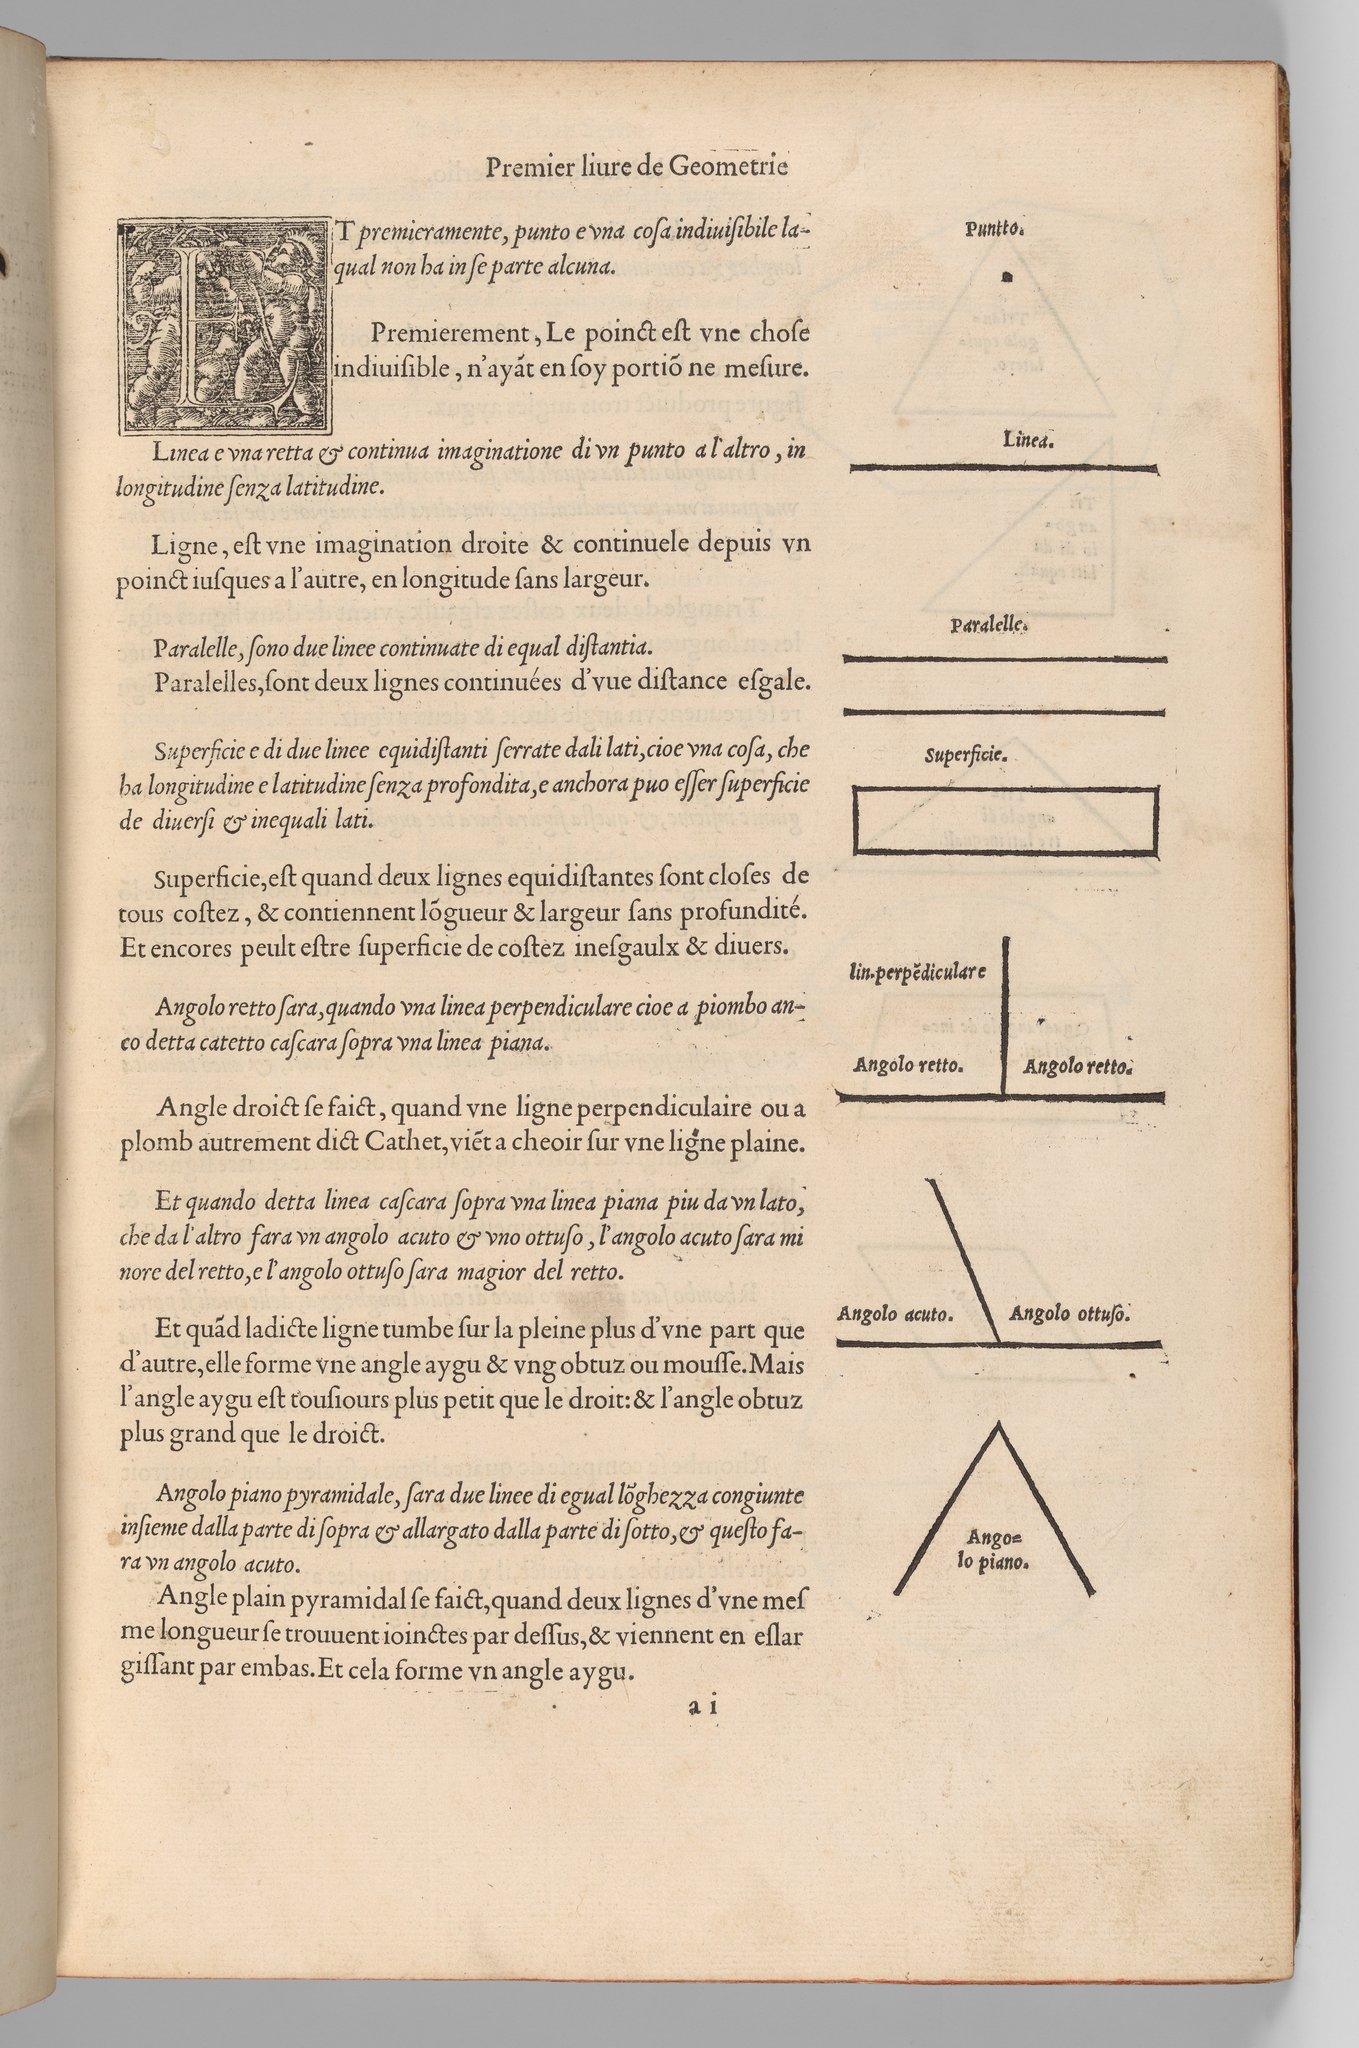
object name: book print ornament architecture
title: Il primo libro d'architettura di Sebastiano Serlio Bolognese. Il secondo libro di perspecttia di Sebastiano Serlio, Bolognese.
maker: sebastiano serlio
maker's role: author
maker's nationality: italian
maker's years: 1475-1554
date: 1545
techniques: printing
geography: france